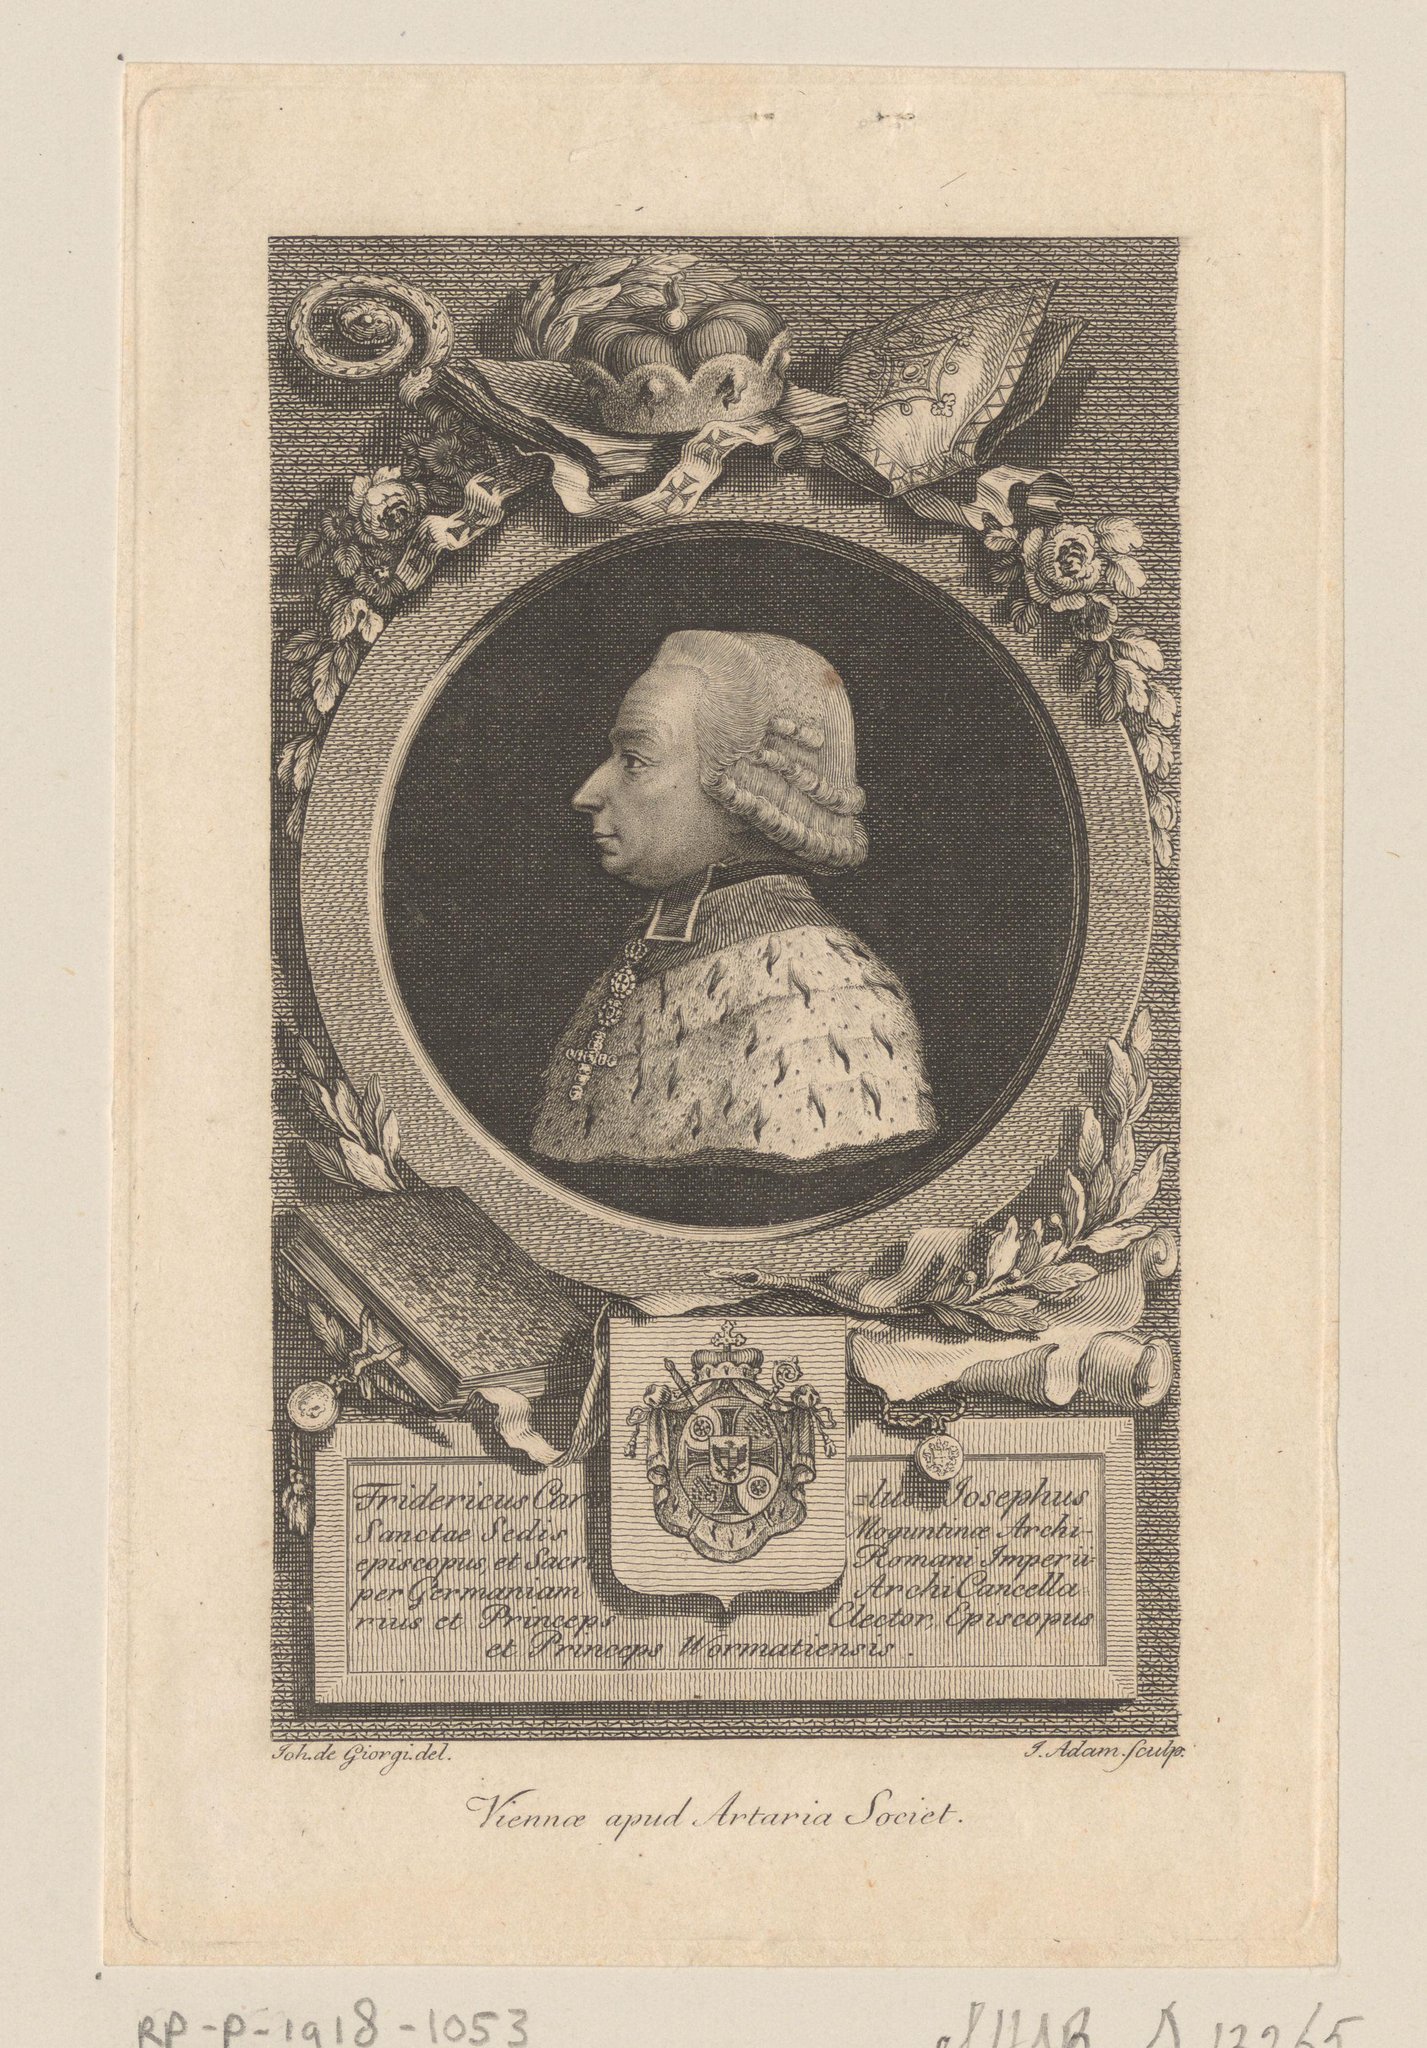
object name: print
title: Portret van Friedrich Karl Joseph von Erthal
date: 1774-1802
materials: paper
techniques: engraving, etching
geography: vienna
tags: insignia of bishop, e.g. mitre, crozier, historical persons, armorial bearing, heraldry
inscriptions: collector's mark: Lugt 2233